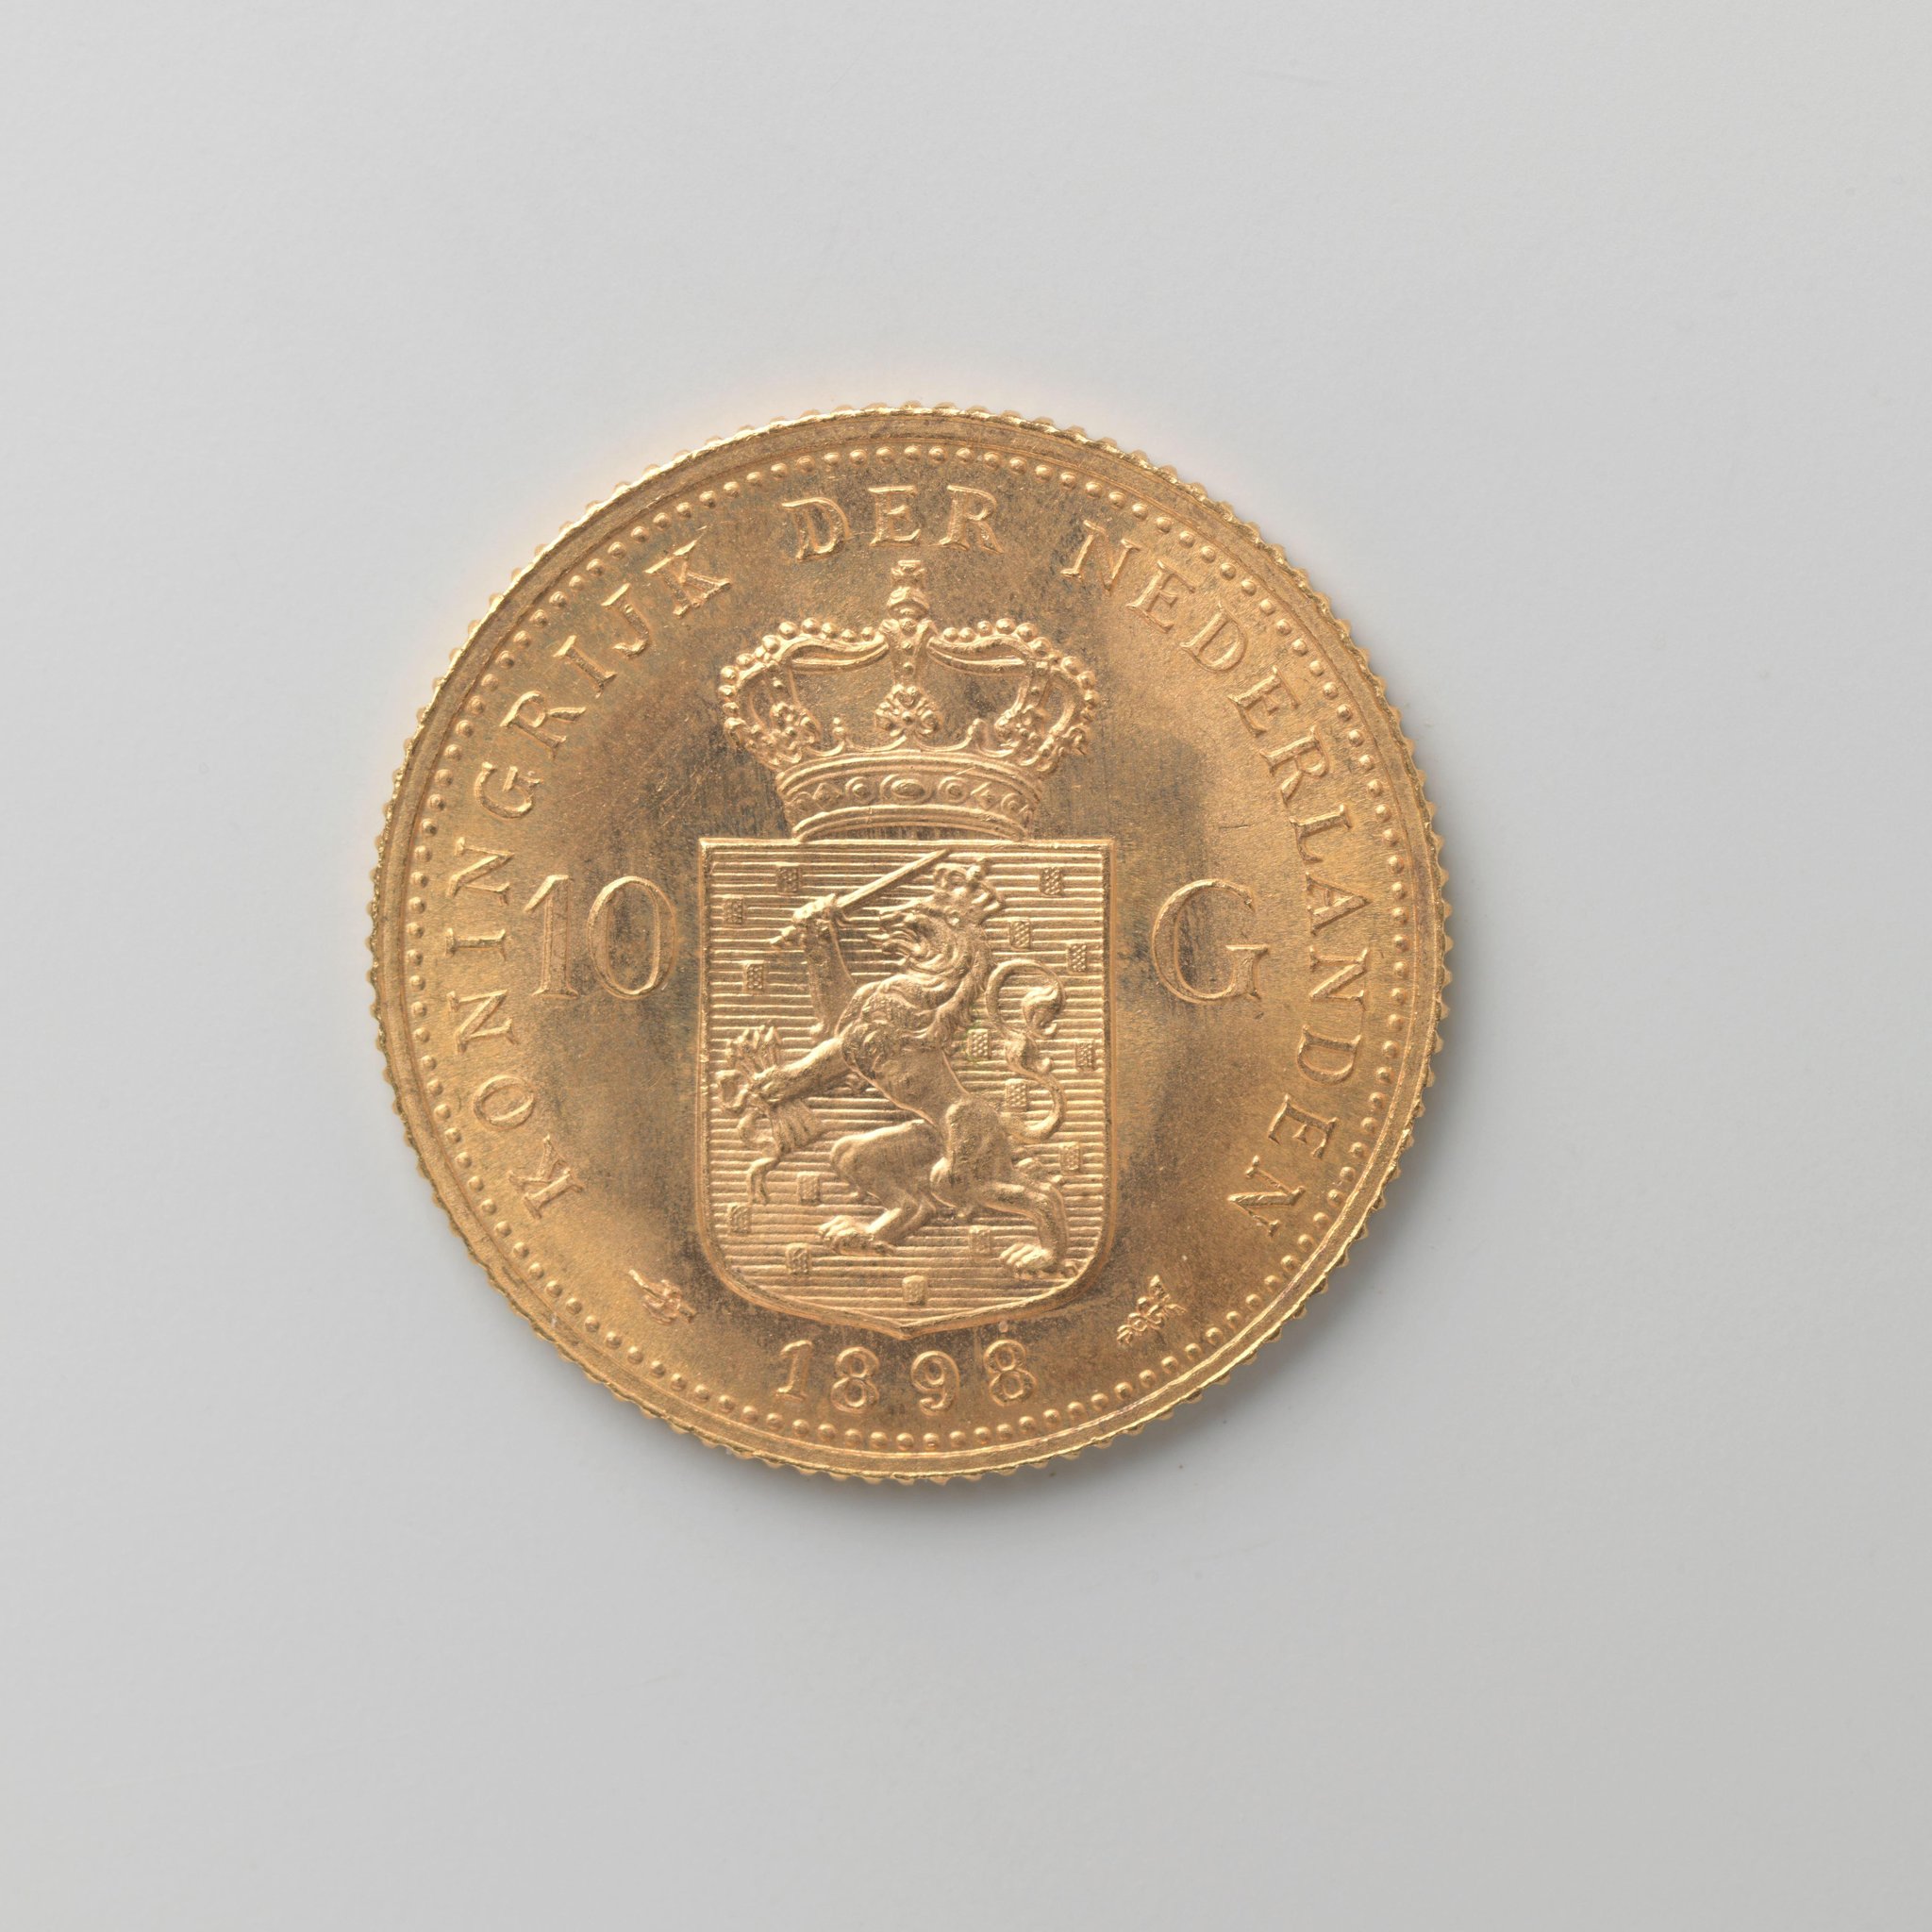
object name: tien gulden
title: Nederlandse10 gulden,1898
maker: wilhelmina of the netherlands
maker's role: print maker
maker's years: 1880-1962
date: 1898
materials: gold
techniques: striking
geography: utrecht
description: Gouden munt. Voorzijde: hoofd met diadeem naar rechts. Keerzijde: tussen waarde-aanduiding 10 G gekroond rijkswapenschild. Jaartal onderaan in omschrift. Kartelrand.